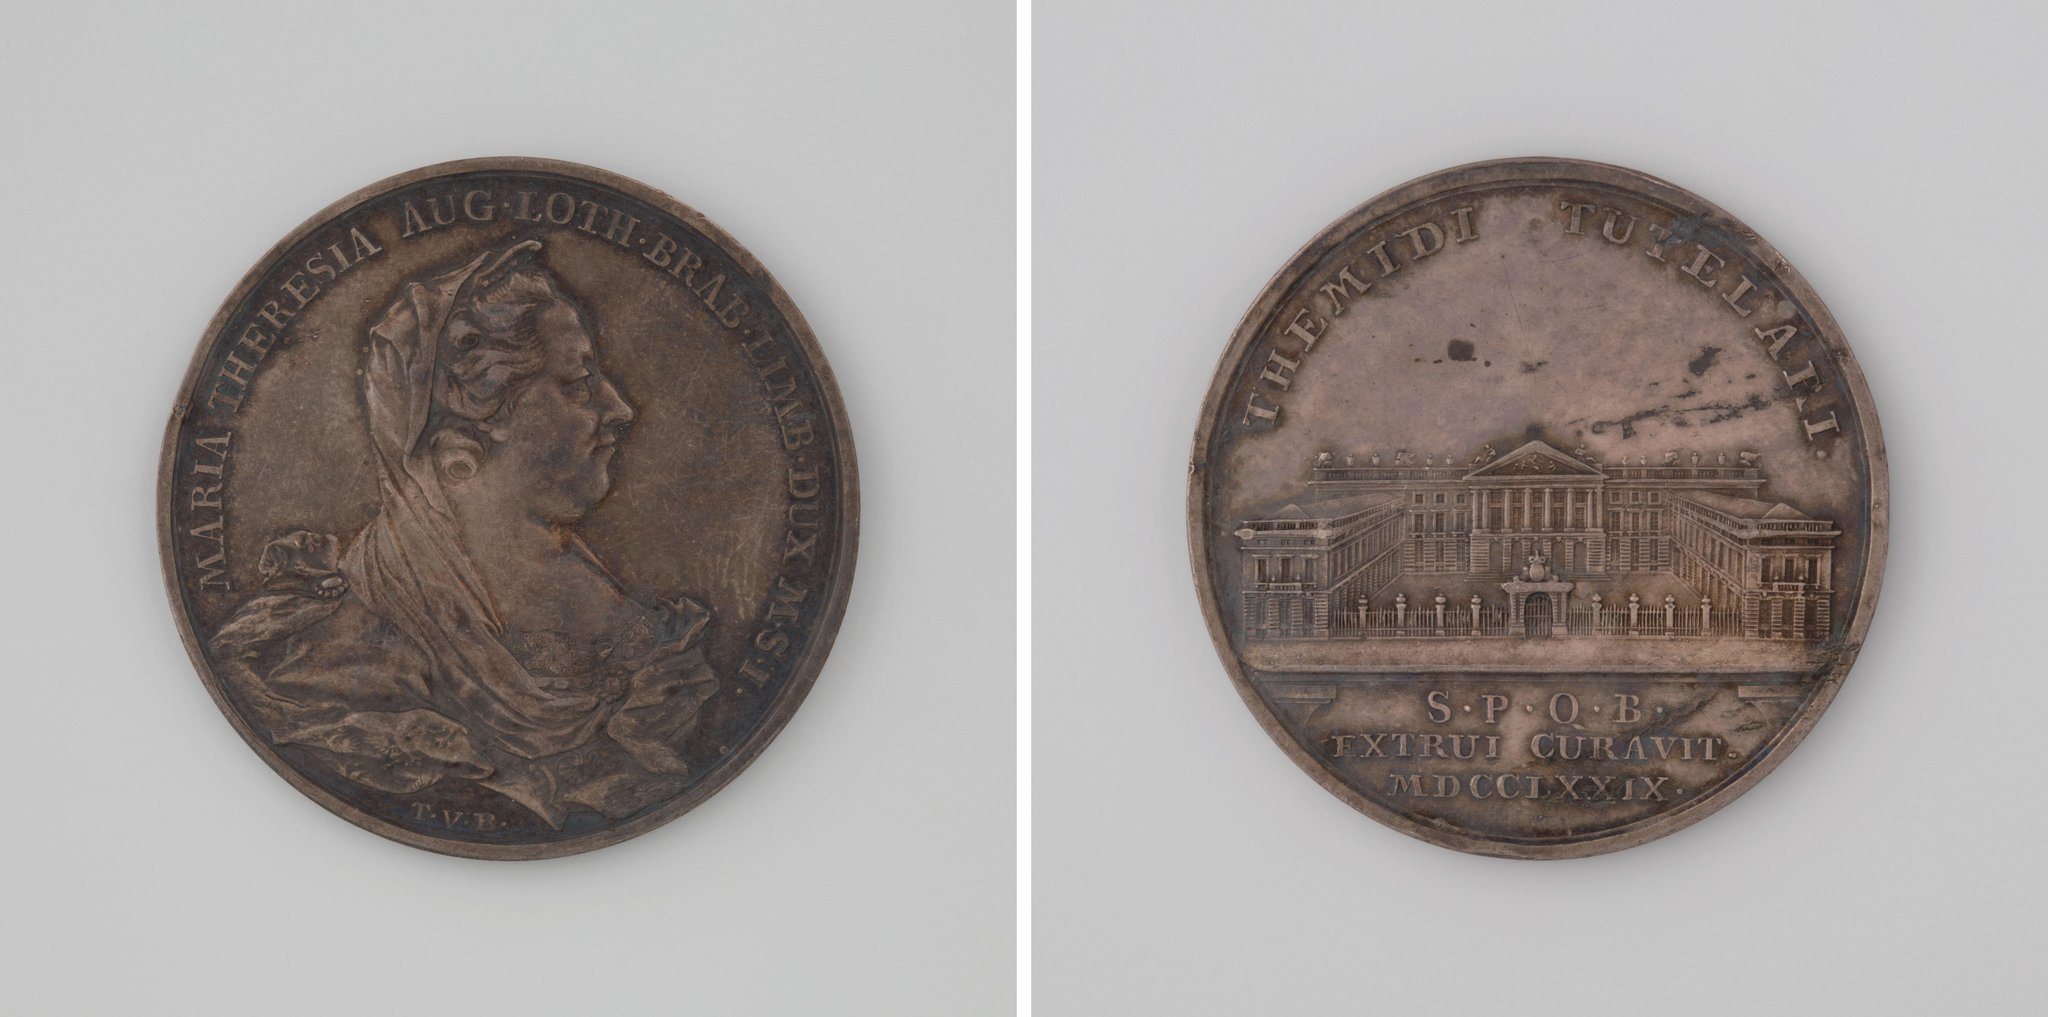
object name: history medal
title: Verbouwing van het paleis van Justitie te Brussel, ter ere van Maria Theresia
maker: theodorus victor van berckel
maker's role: mintmaster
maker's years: 1739-1808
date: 1779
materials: silver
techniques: striking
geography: brussels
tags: maria theresia (rooms-duits keizerin), brussels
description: Zilveren penning. Voorzijde: borststuk gesluierde vrouw binnen omschrift. Keerzijde: paleis van Justitie binnen omschrift; afsnede: opschrift